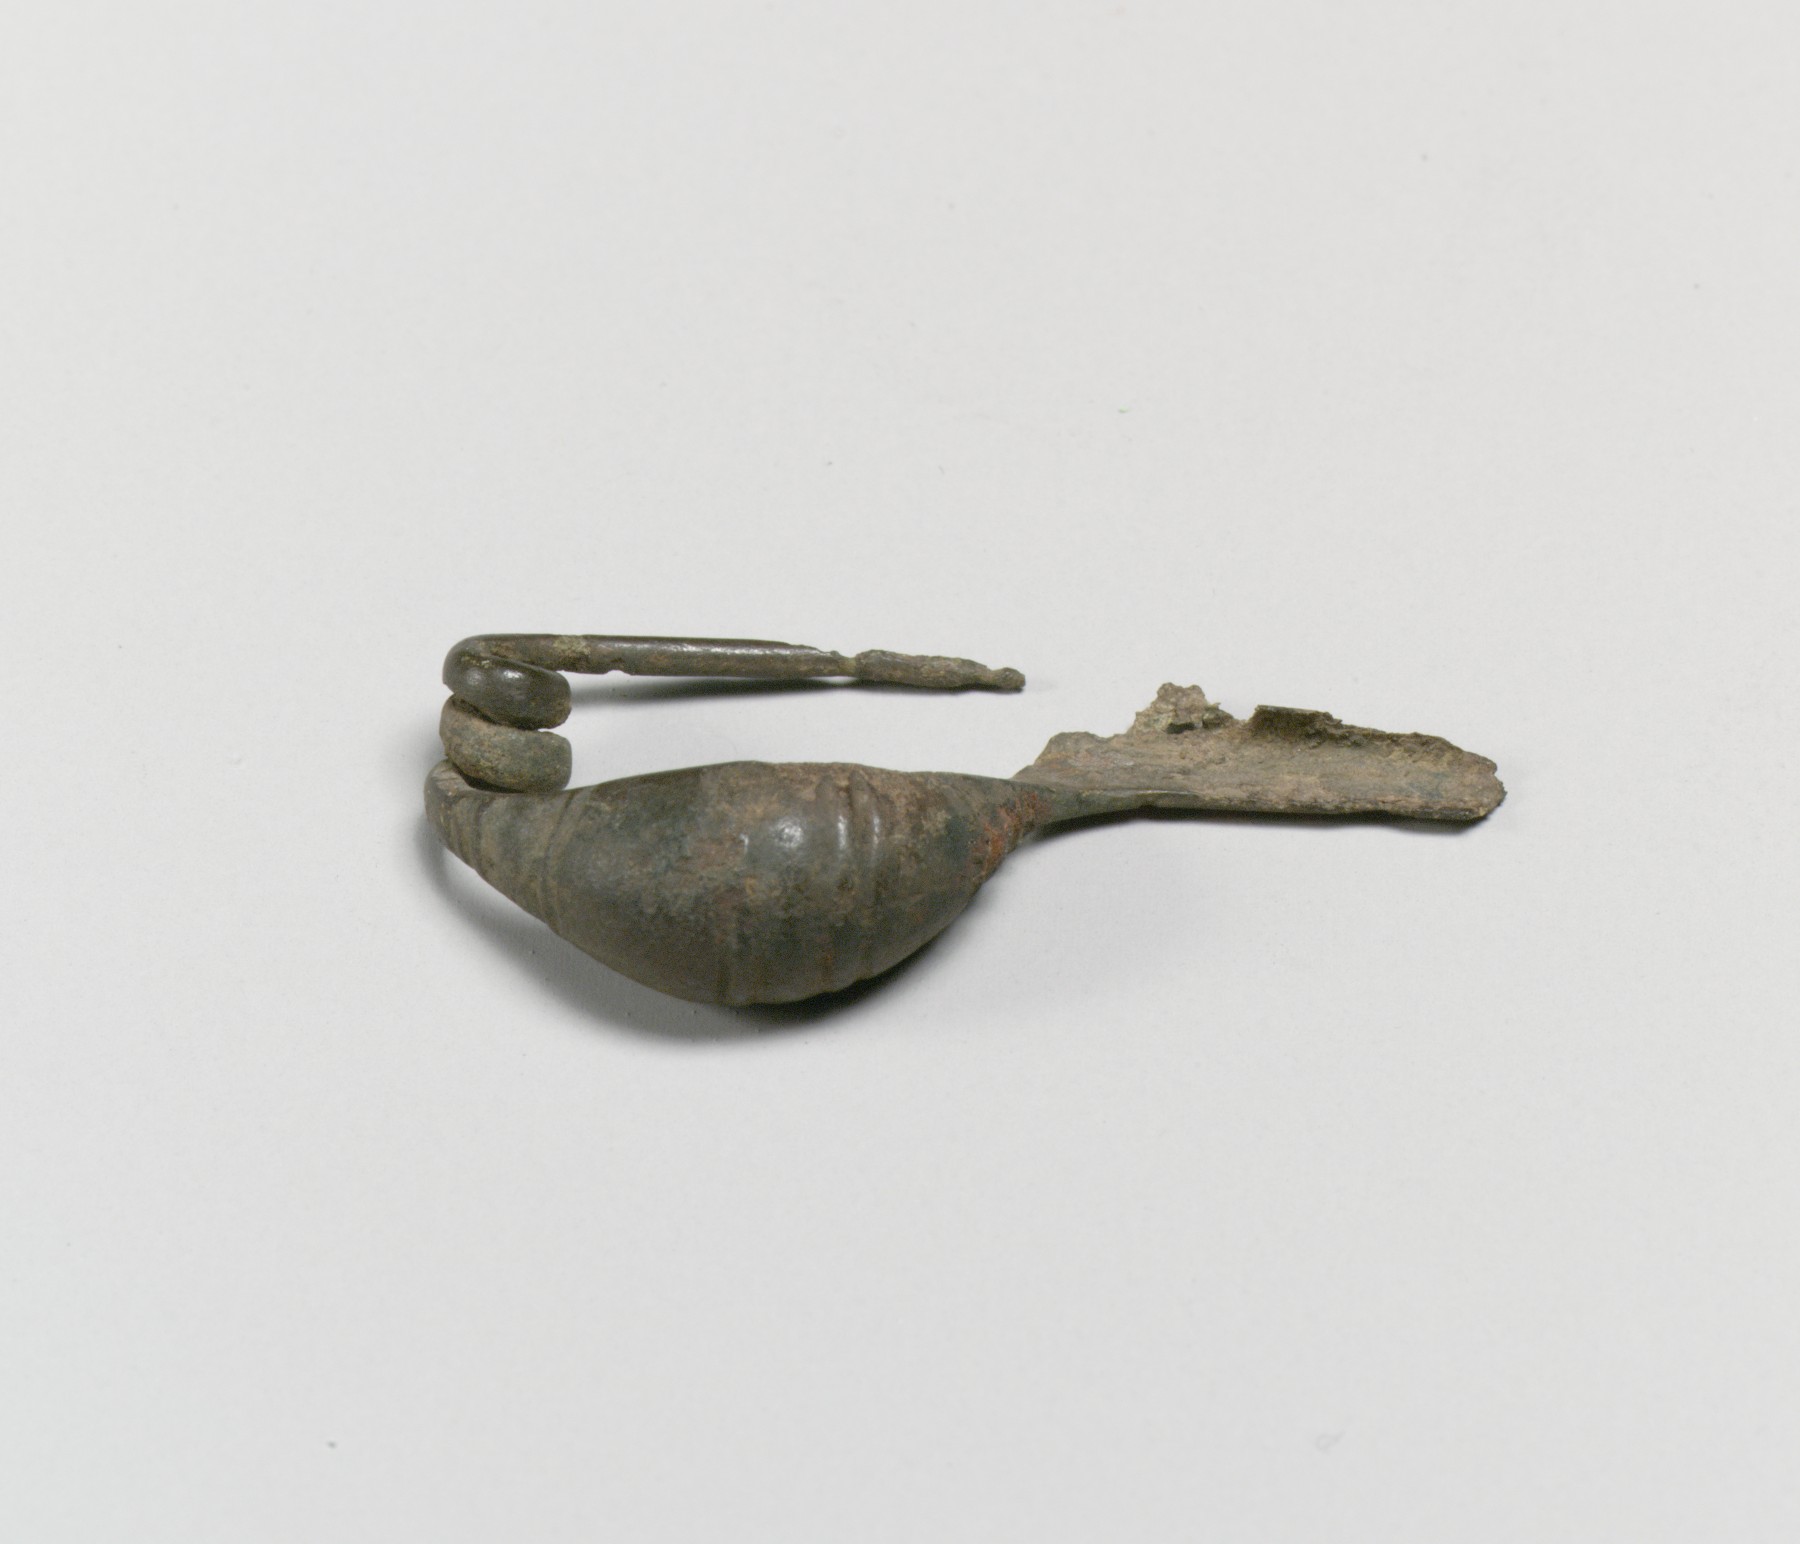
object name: fibula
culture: italic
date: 800-501 BCE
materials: bronze